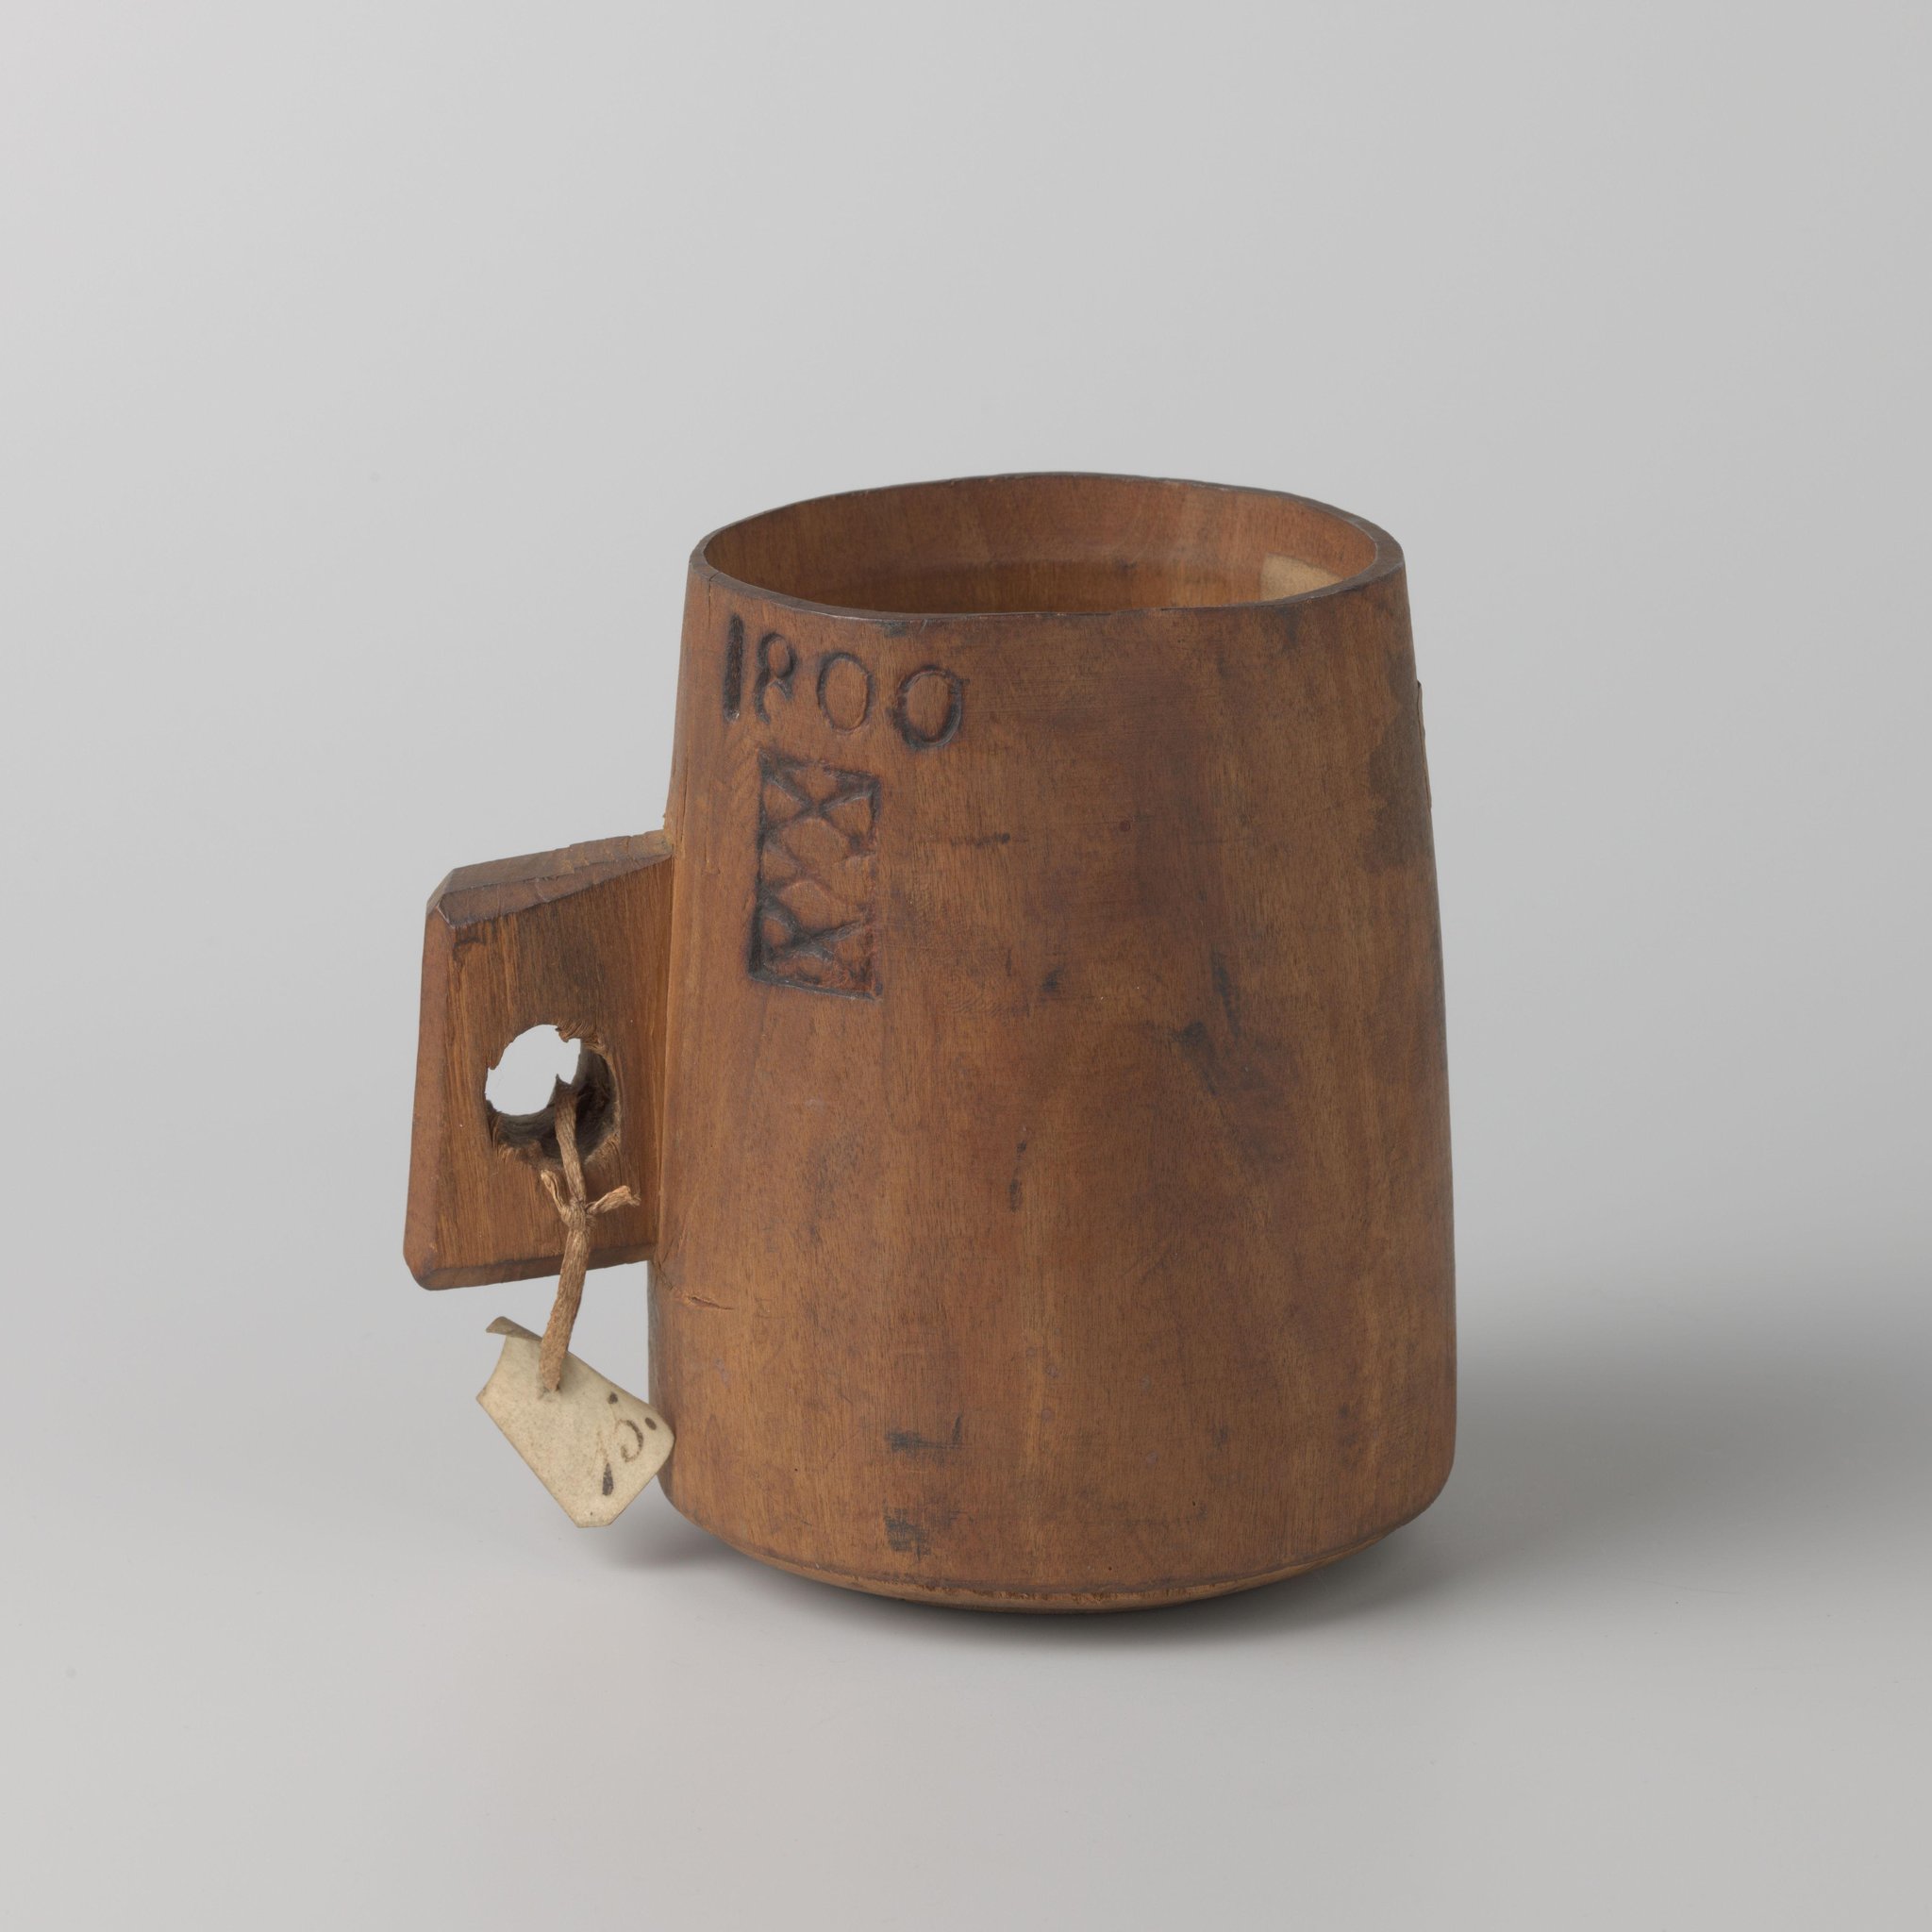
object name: melkmaat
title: Een pints melkmaat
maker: Anonymous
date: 1800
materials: wood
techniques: turning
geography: amsterdam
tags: amsterdam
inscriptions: : ‘1800 nr 15 / d'Amsterdam mesure’, inscription: ‘Amsterdam / Een Pints Melkmaat’, inscription: ‘15’, inscription: ‘à bière’, title: ‘een pint melk’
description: Melkmaat van 1 pint met oor. Gemerkt, getiteld, gelabeld en v.z.v. etiket.